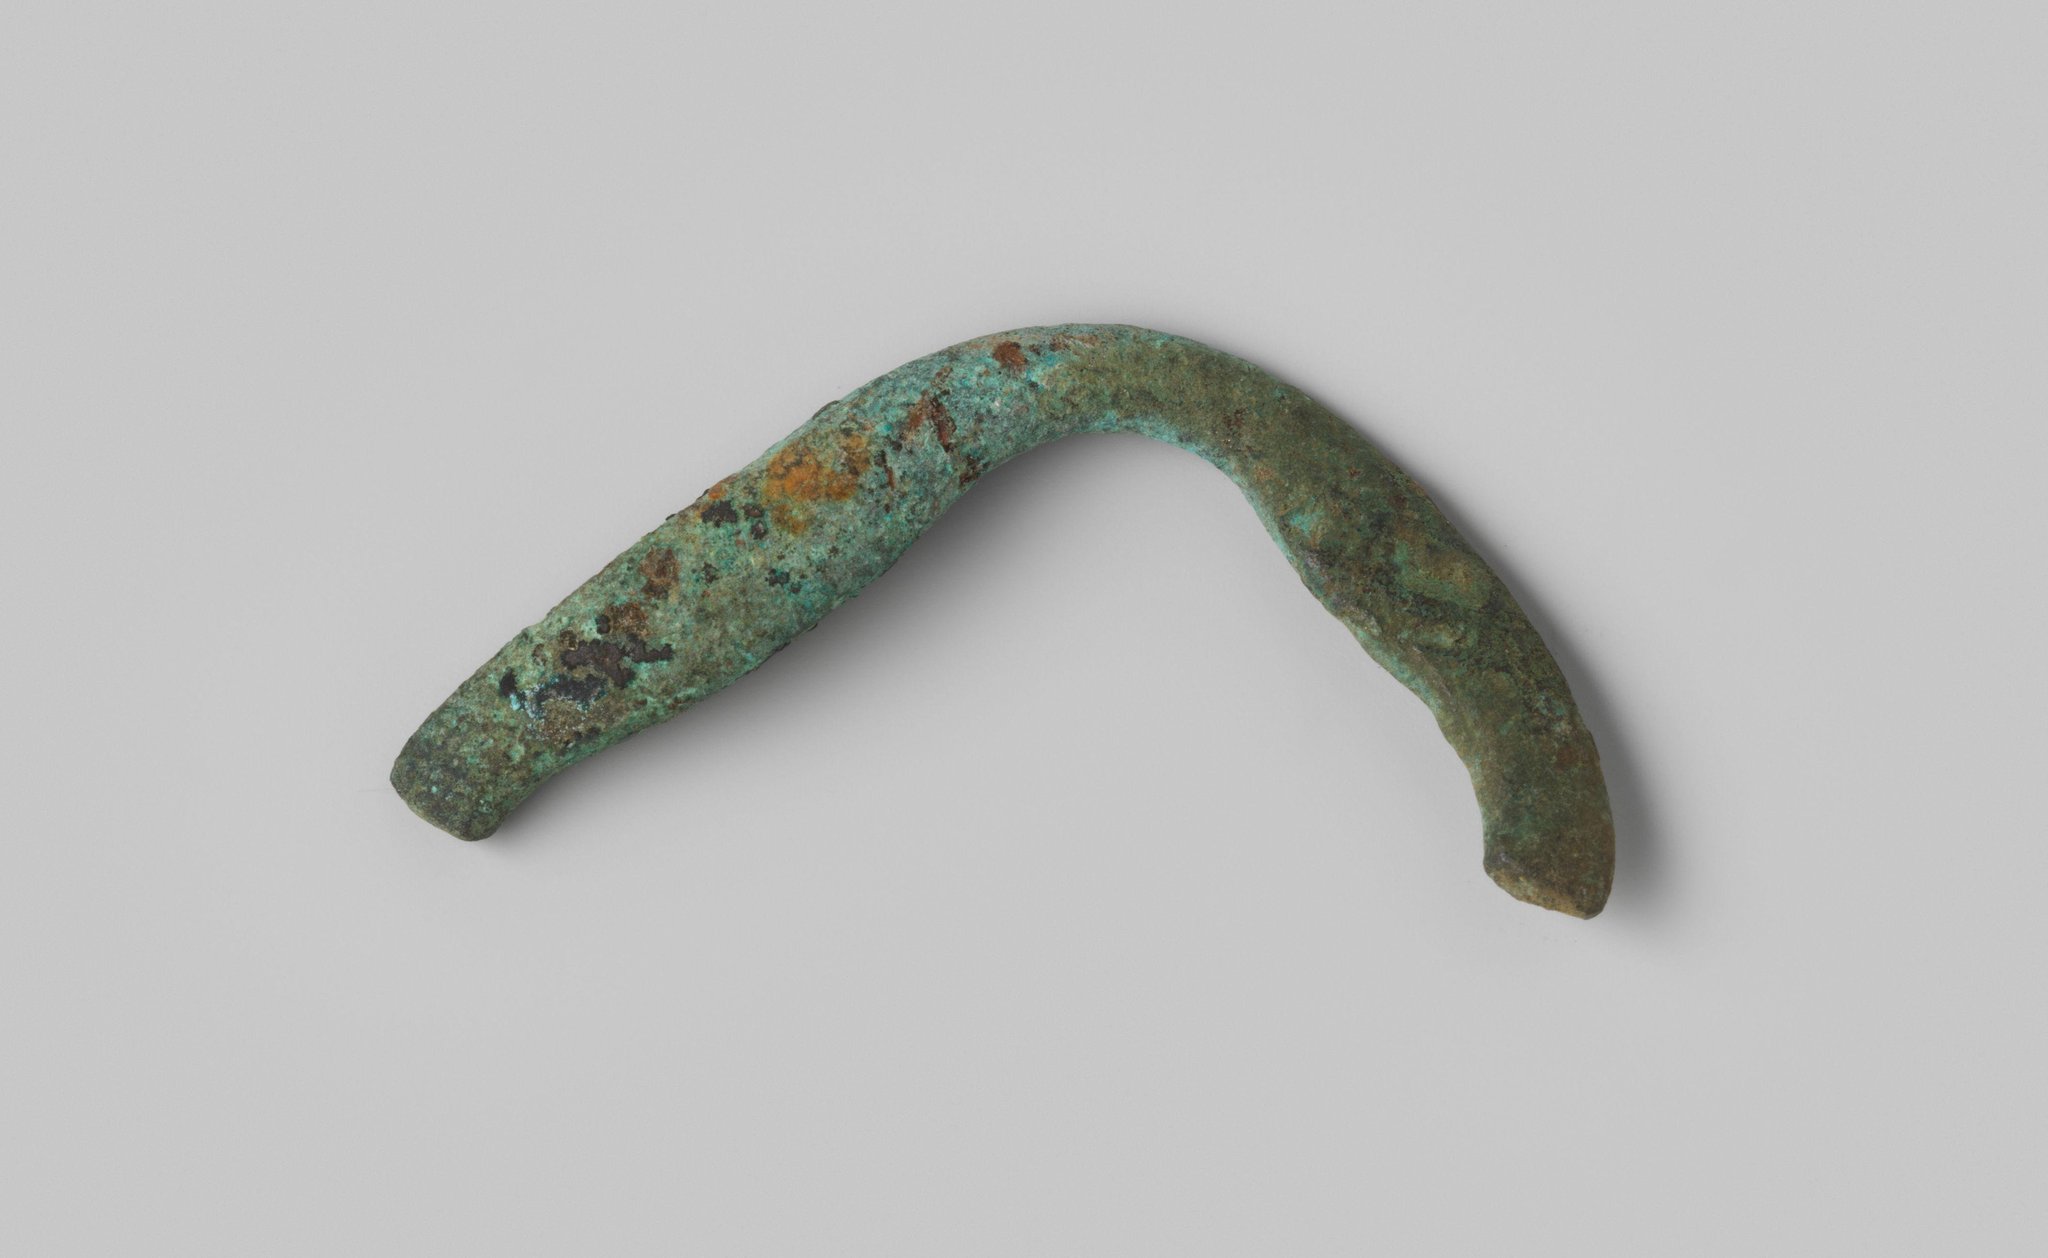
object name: shoe buckle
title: Fragment schoengesp uit het wrak van de Oost-Indiëvaarder Hollandia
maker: Anonymous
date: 1700-1743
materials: copper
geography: netherlands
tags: verenigde oostindische compagnie, hollandia (schip), annet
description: Buckle, chape buckle, shoe buckle; fragment of ring, plain, bulbous sides.